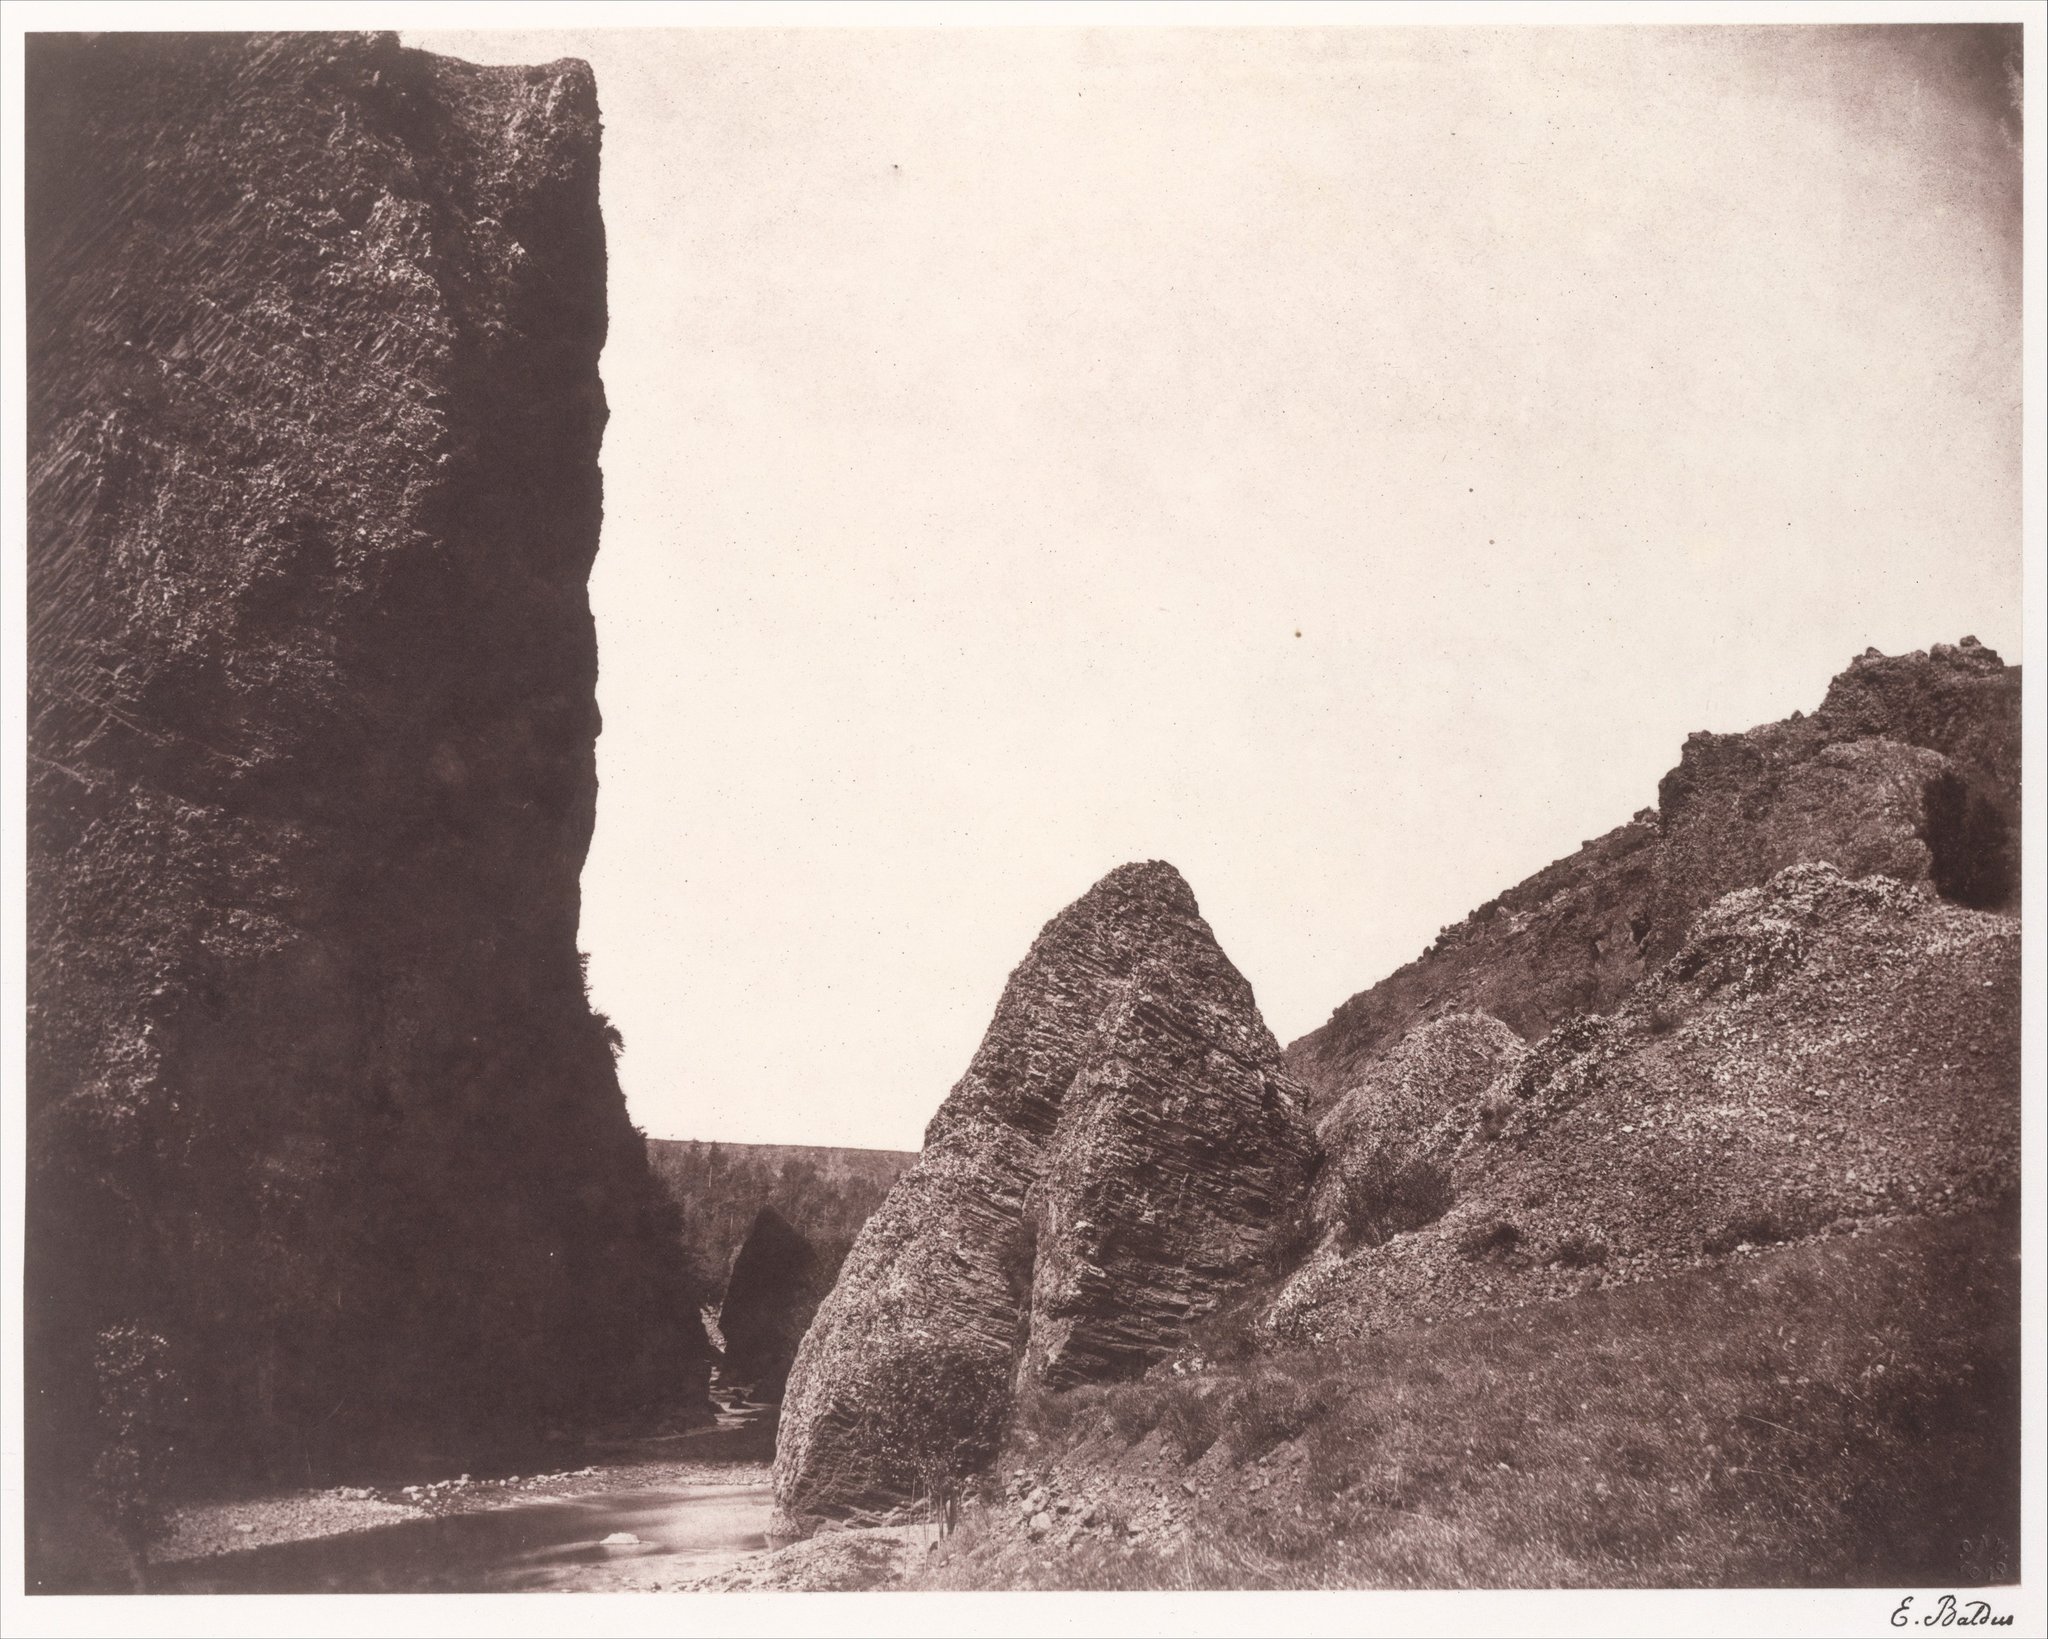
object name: photograph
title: [Rocks in the Auvergne]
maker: édouard denis baldus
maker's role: fotograaf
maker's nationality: french, born prussia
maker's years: 1813-1889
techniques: paper negative, salted paper print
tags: landscapes